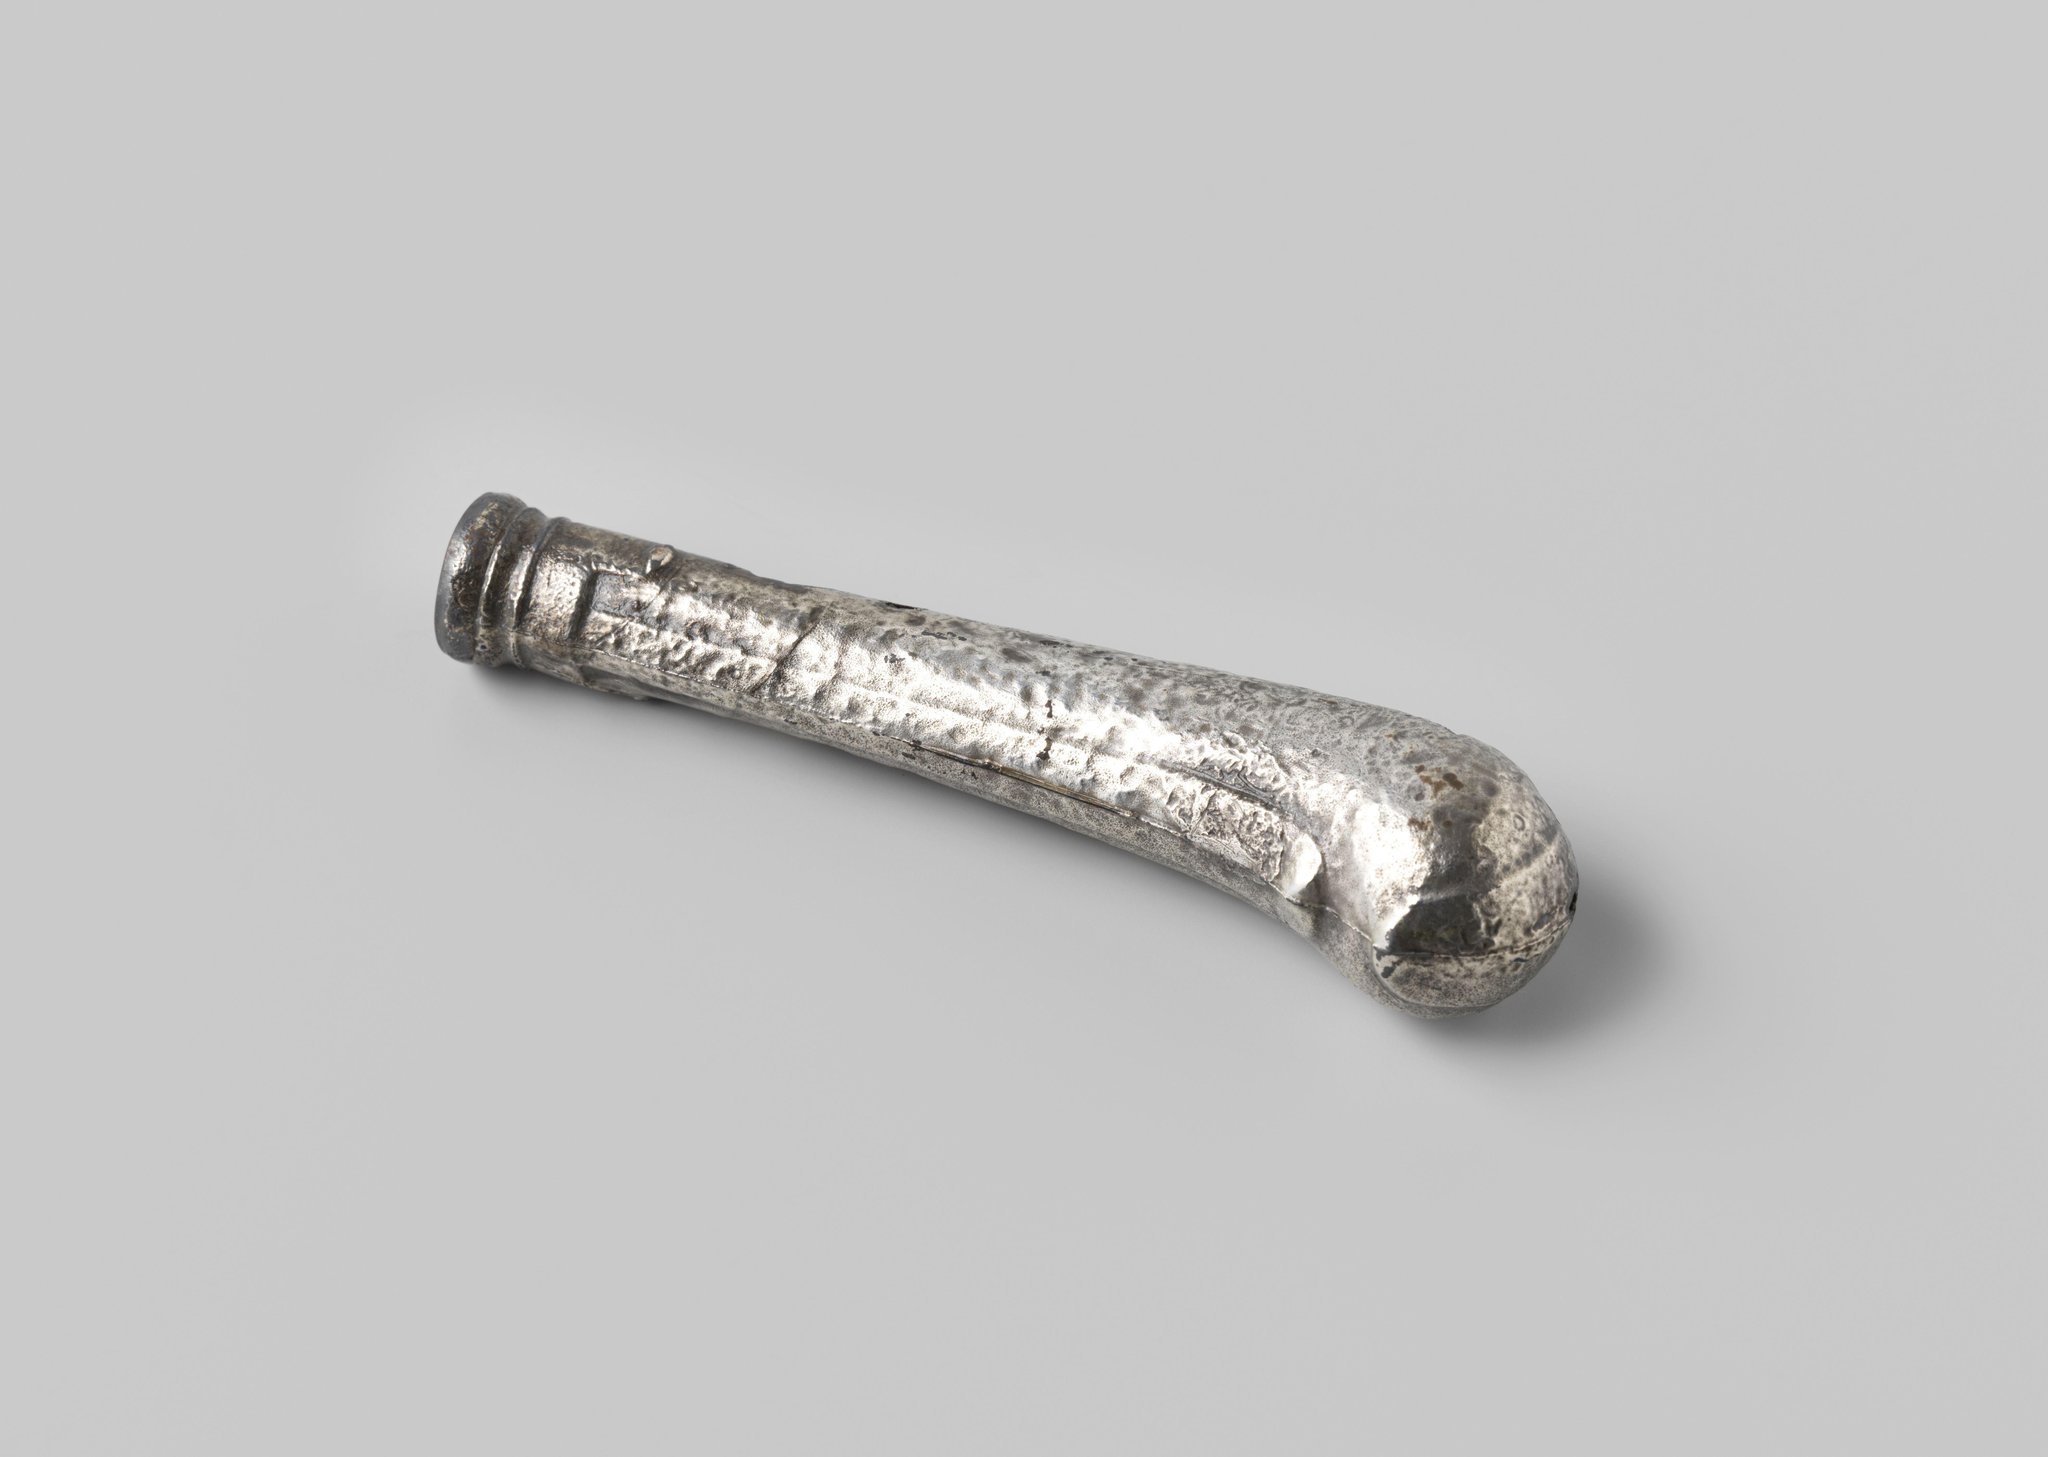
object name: handle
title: Silver knife handle from the wreck of the Dutch East Indiaman Hollandia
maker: Anonymous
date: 1700-1743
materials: silver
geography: netherlands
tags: verenigde oostindische compagnie, hollandia (schip), annet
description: Cutlery, knive; fragm, handle, id. NG 1980-27H733, with id. coat of arms.